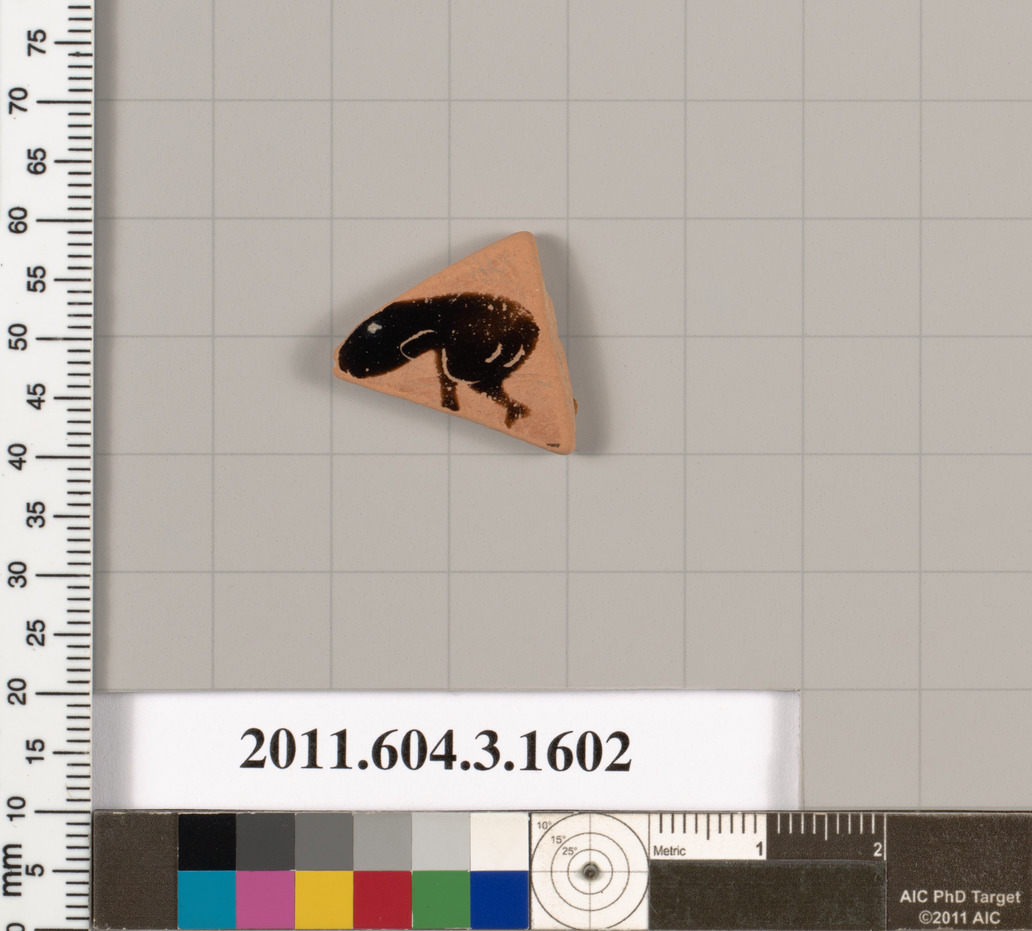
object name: kylix fragment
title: Terracotta fragment of a kylix: Band cup (drinking cup)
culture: greek, attic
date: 550-526 BCE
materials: terracotta